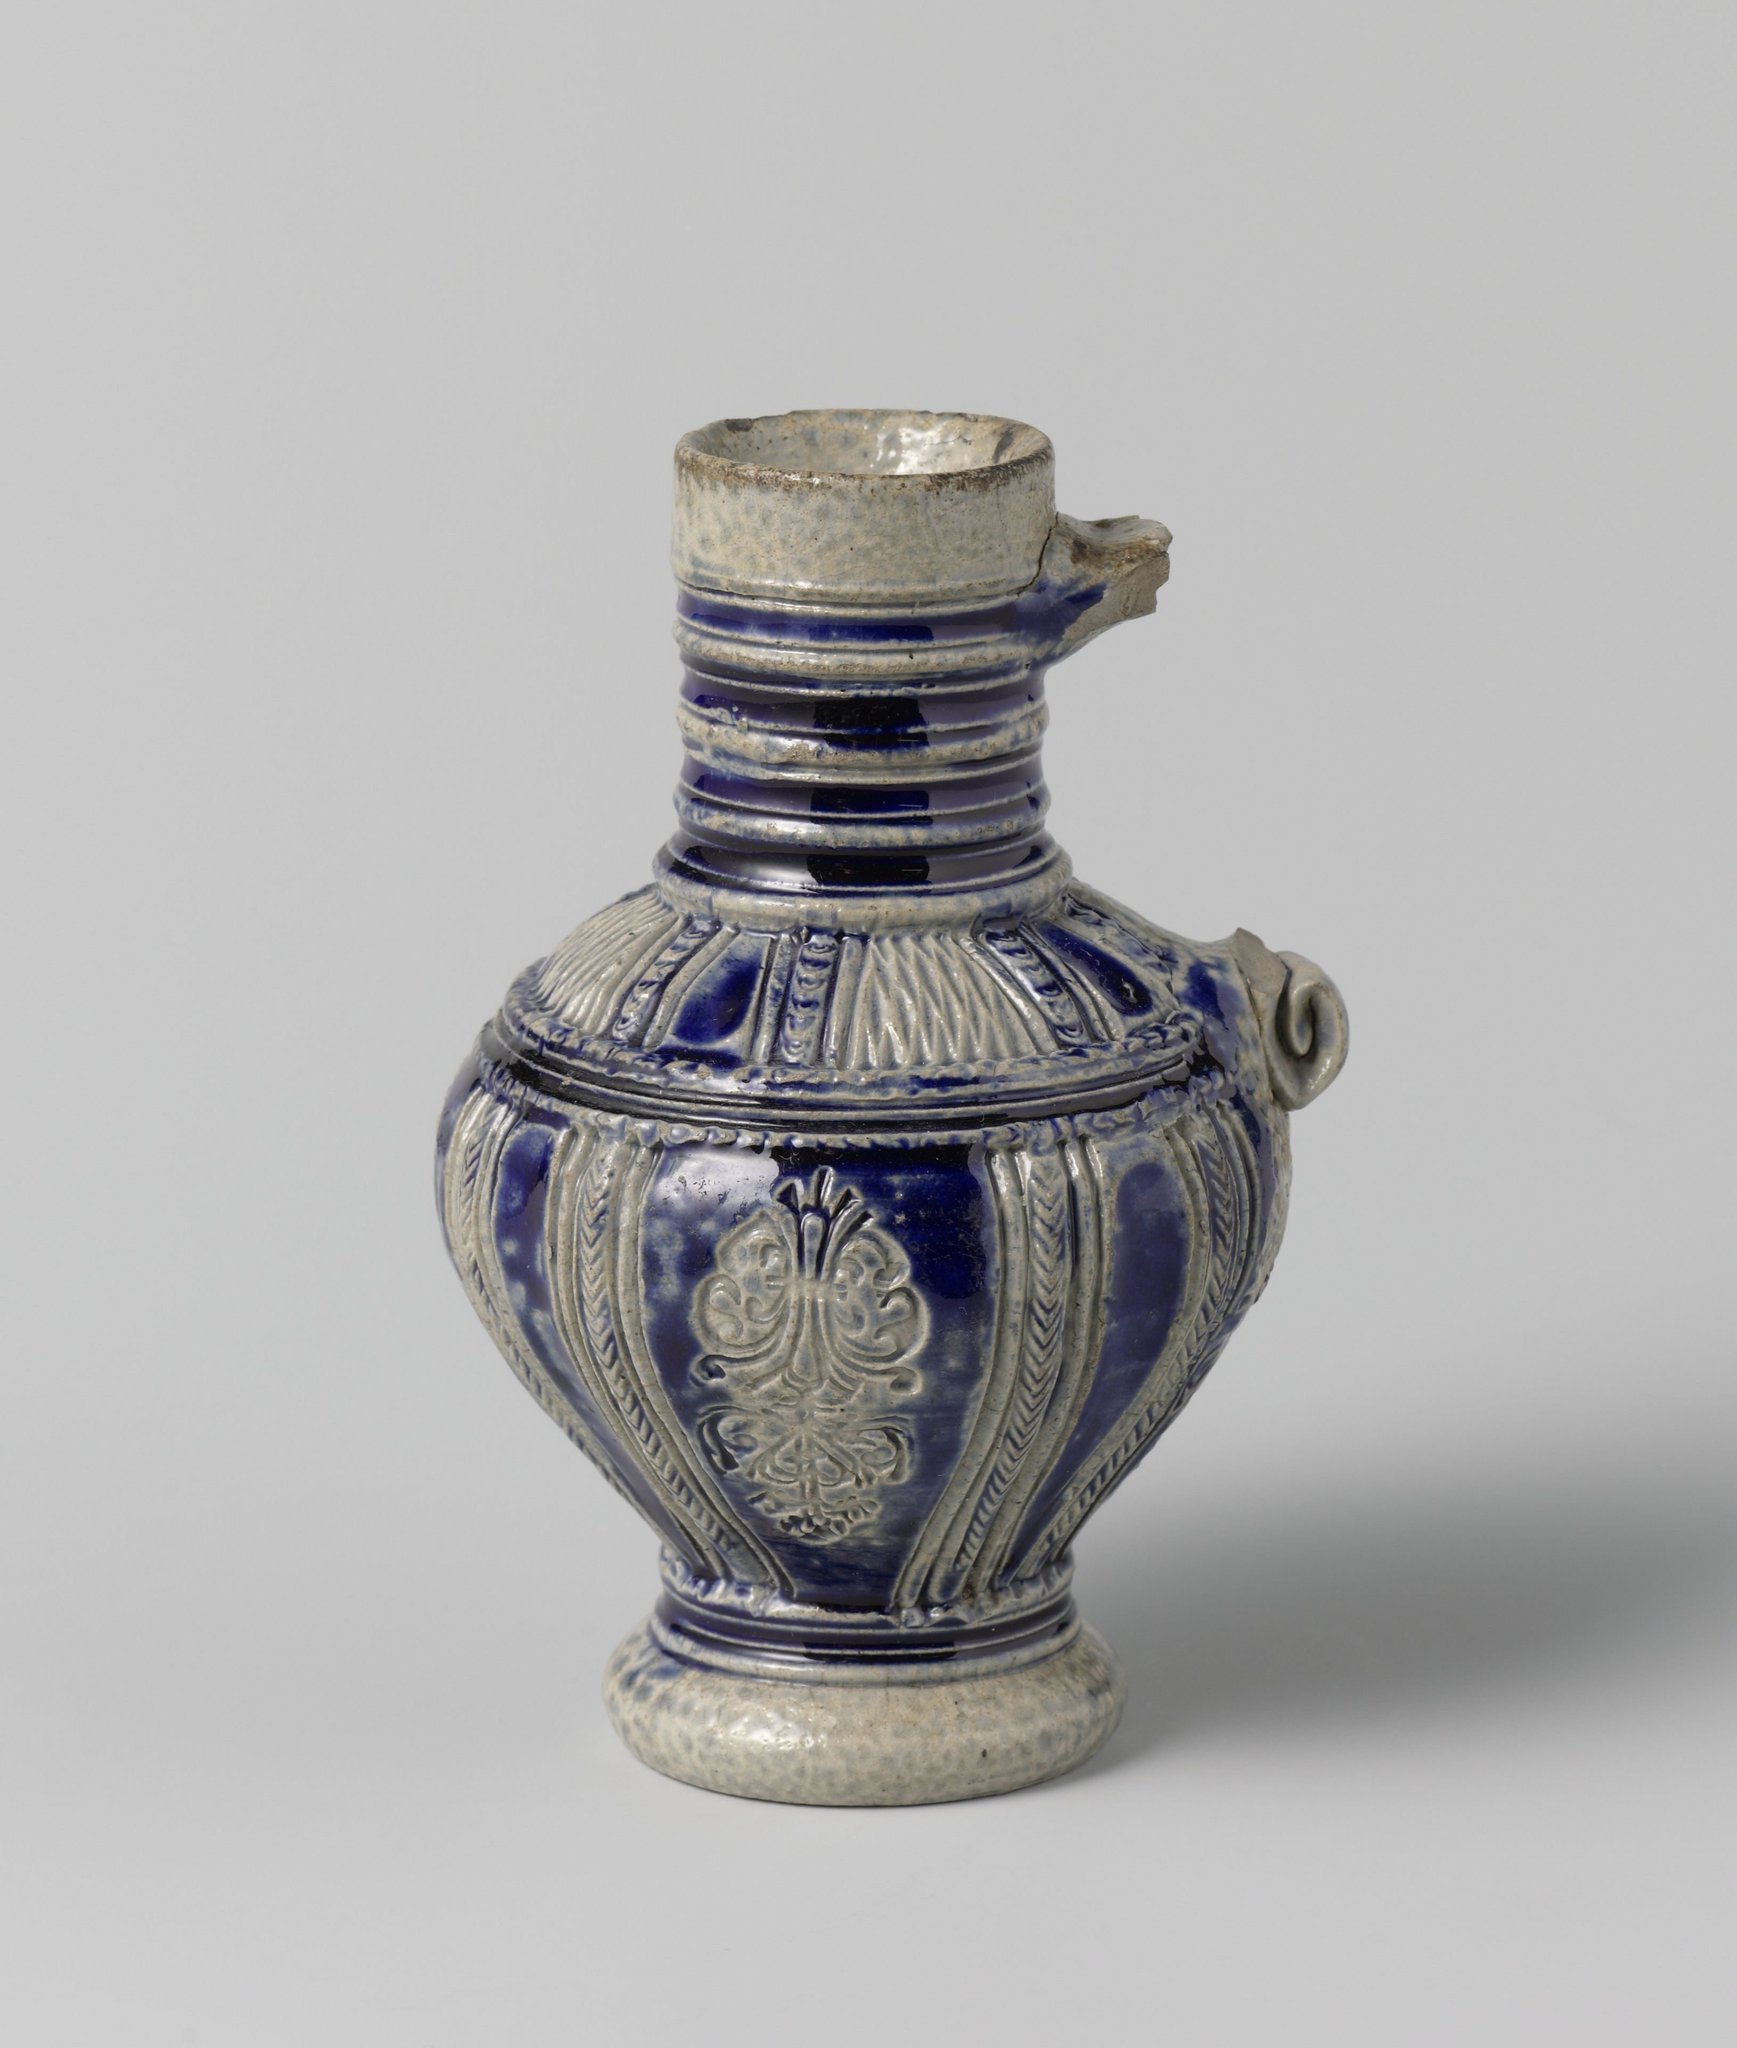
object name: jug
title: Jug with a panel decoration and scrolls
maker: Anonymous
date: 1590-1620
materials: cobalt, glaze, stoneware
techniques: printing, firing, forming, turning, vitrification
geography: westerwald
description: Kleine kruik van steengoed op hoge voet met een eivormig lichaan en smalle nek. Het (afgebroken) C-vormige oor is bevestigd aan de nek en de schouder. Profielen op de nek en voet. Gedeeltelijk bedekt met kobaltblauw. De buik is verdeeld in brede en smalle vakken, gescheiden door een profiel. In de brede vakken gestempeld krulwerk. De schouder met dezelfde decoratie, alleen zijn hier de brede vakken gevuld met kerfsnede. Raeren/Westerwald.